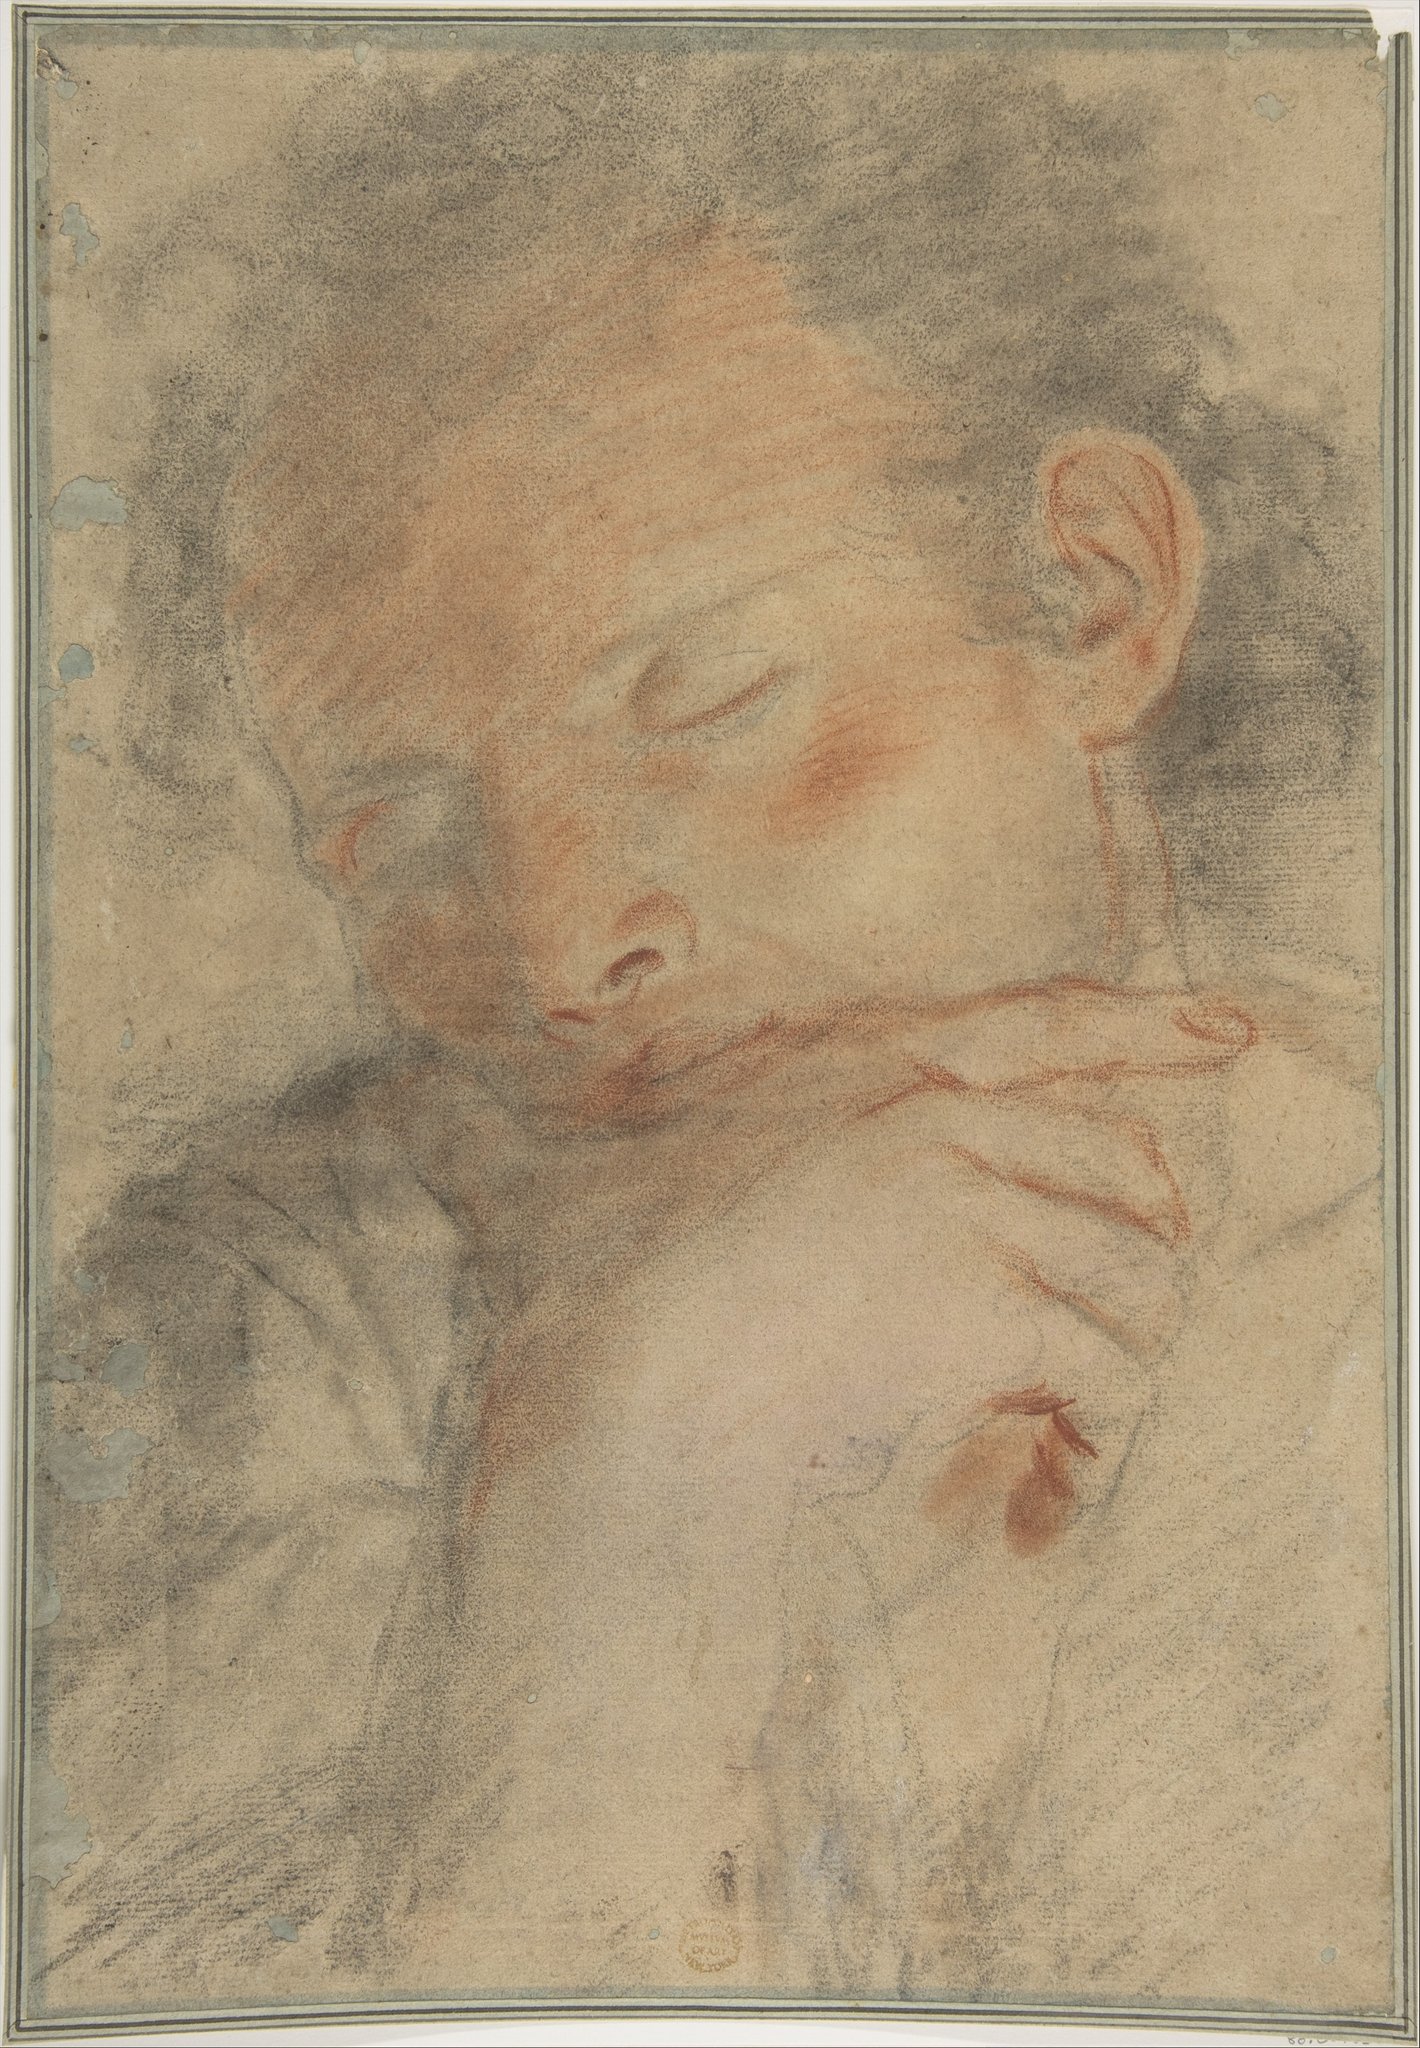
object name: drawing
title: Head of a Man with Closed Eyes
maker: francesco vanni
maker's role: artist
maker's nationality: italian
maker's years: 1563-1610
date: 1563-1610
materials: chalk, paper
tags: eyes,heads,men,portraits